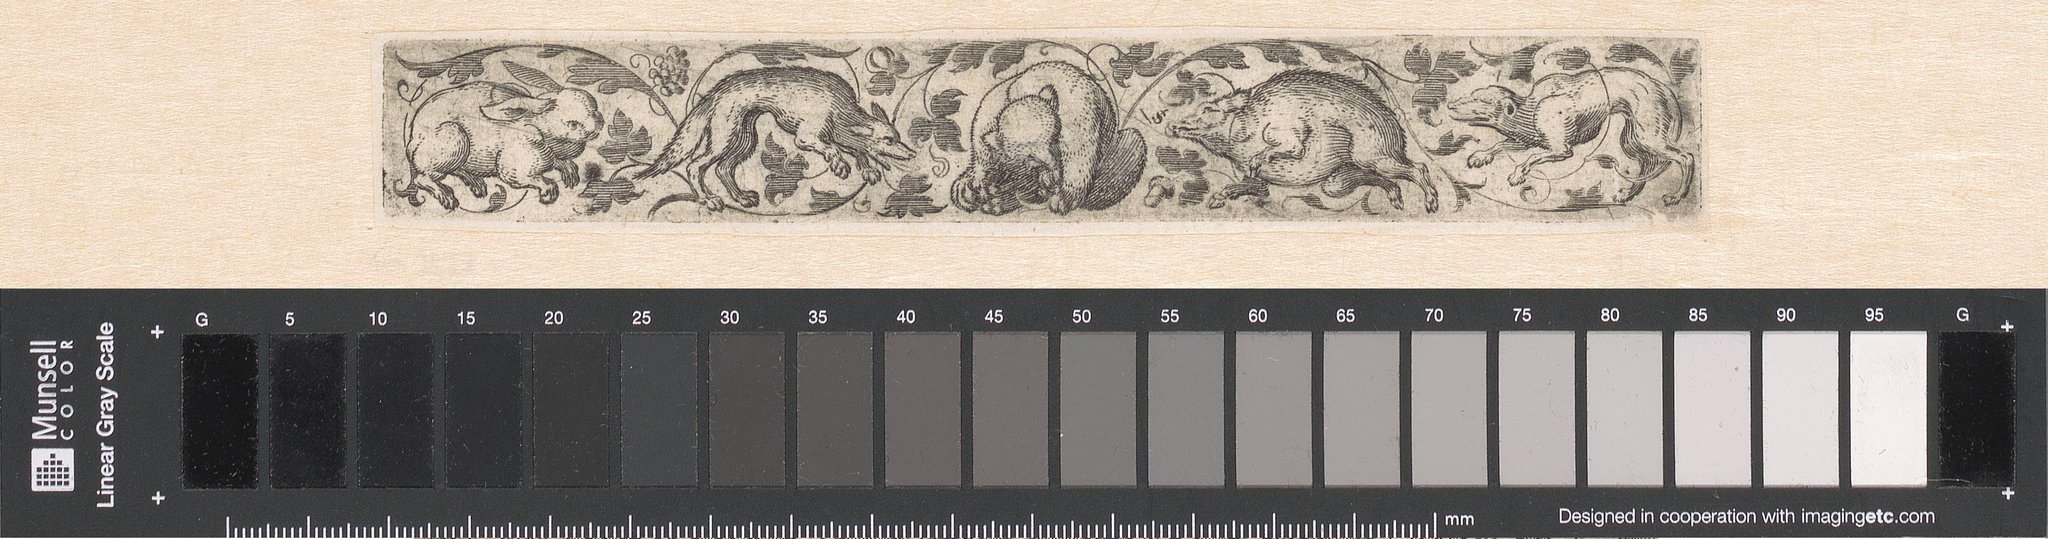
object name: ornament print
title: Fries met gebladerte en vijf dieren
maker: virgilius solis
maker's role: draughtsman, print maker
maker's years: 1514-1562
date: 1524-1562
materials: paper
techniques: engraving, etching, intaglio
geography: nuremberg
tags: foliage, tendrils, branches ~ ornament, rodents: rabbit (+ ornamental variants of animals)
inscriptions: number: ‘33’, collector's mark: Lugt 2228